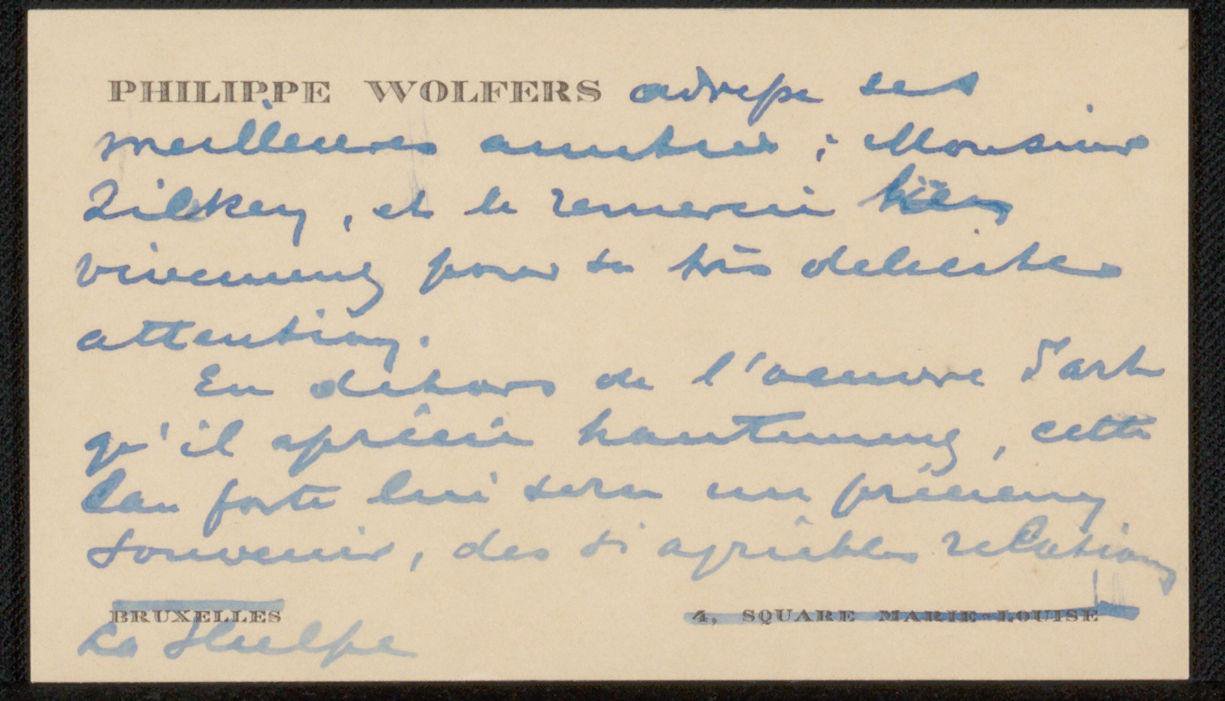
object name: visiting card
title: Visitekaartje aan Philip Zilcken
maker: philippe wolfers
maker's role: designer, goldsmith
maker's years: 1858-1929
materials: cardboard, ink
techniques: pen, printing, writing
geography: brussels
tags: painter, draughtsman, philip zilcken, the graphic arts, exhibition ~ art, brussels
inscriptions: collector's mark: ‘RPK’